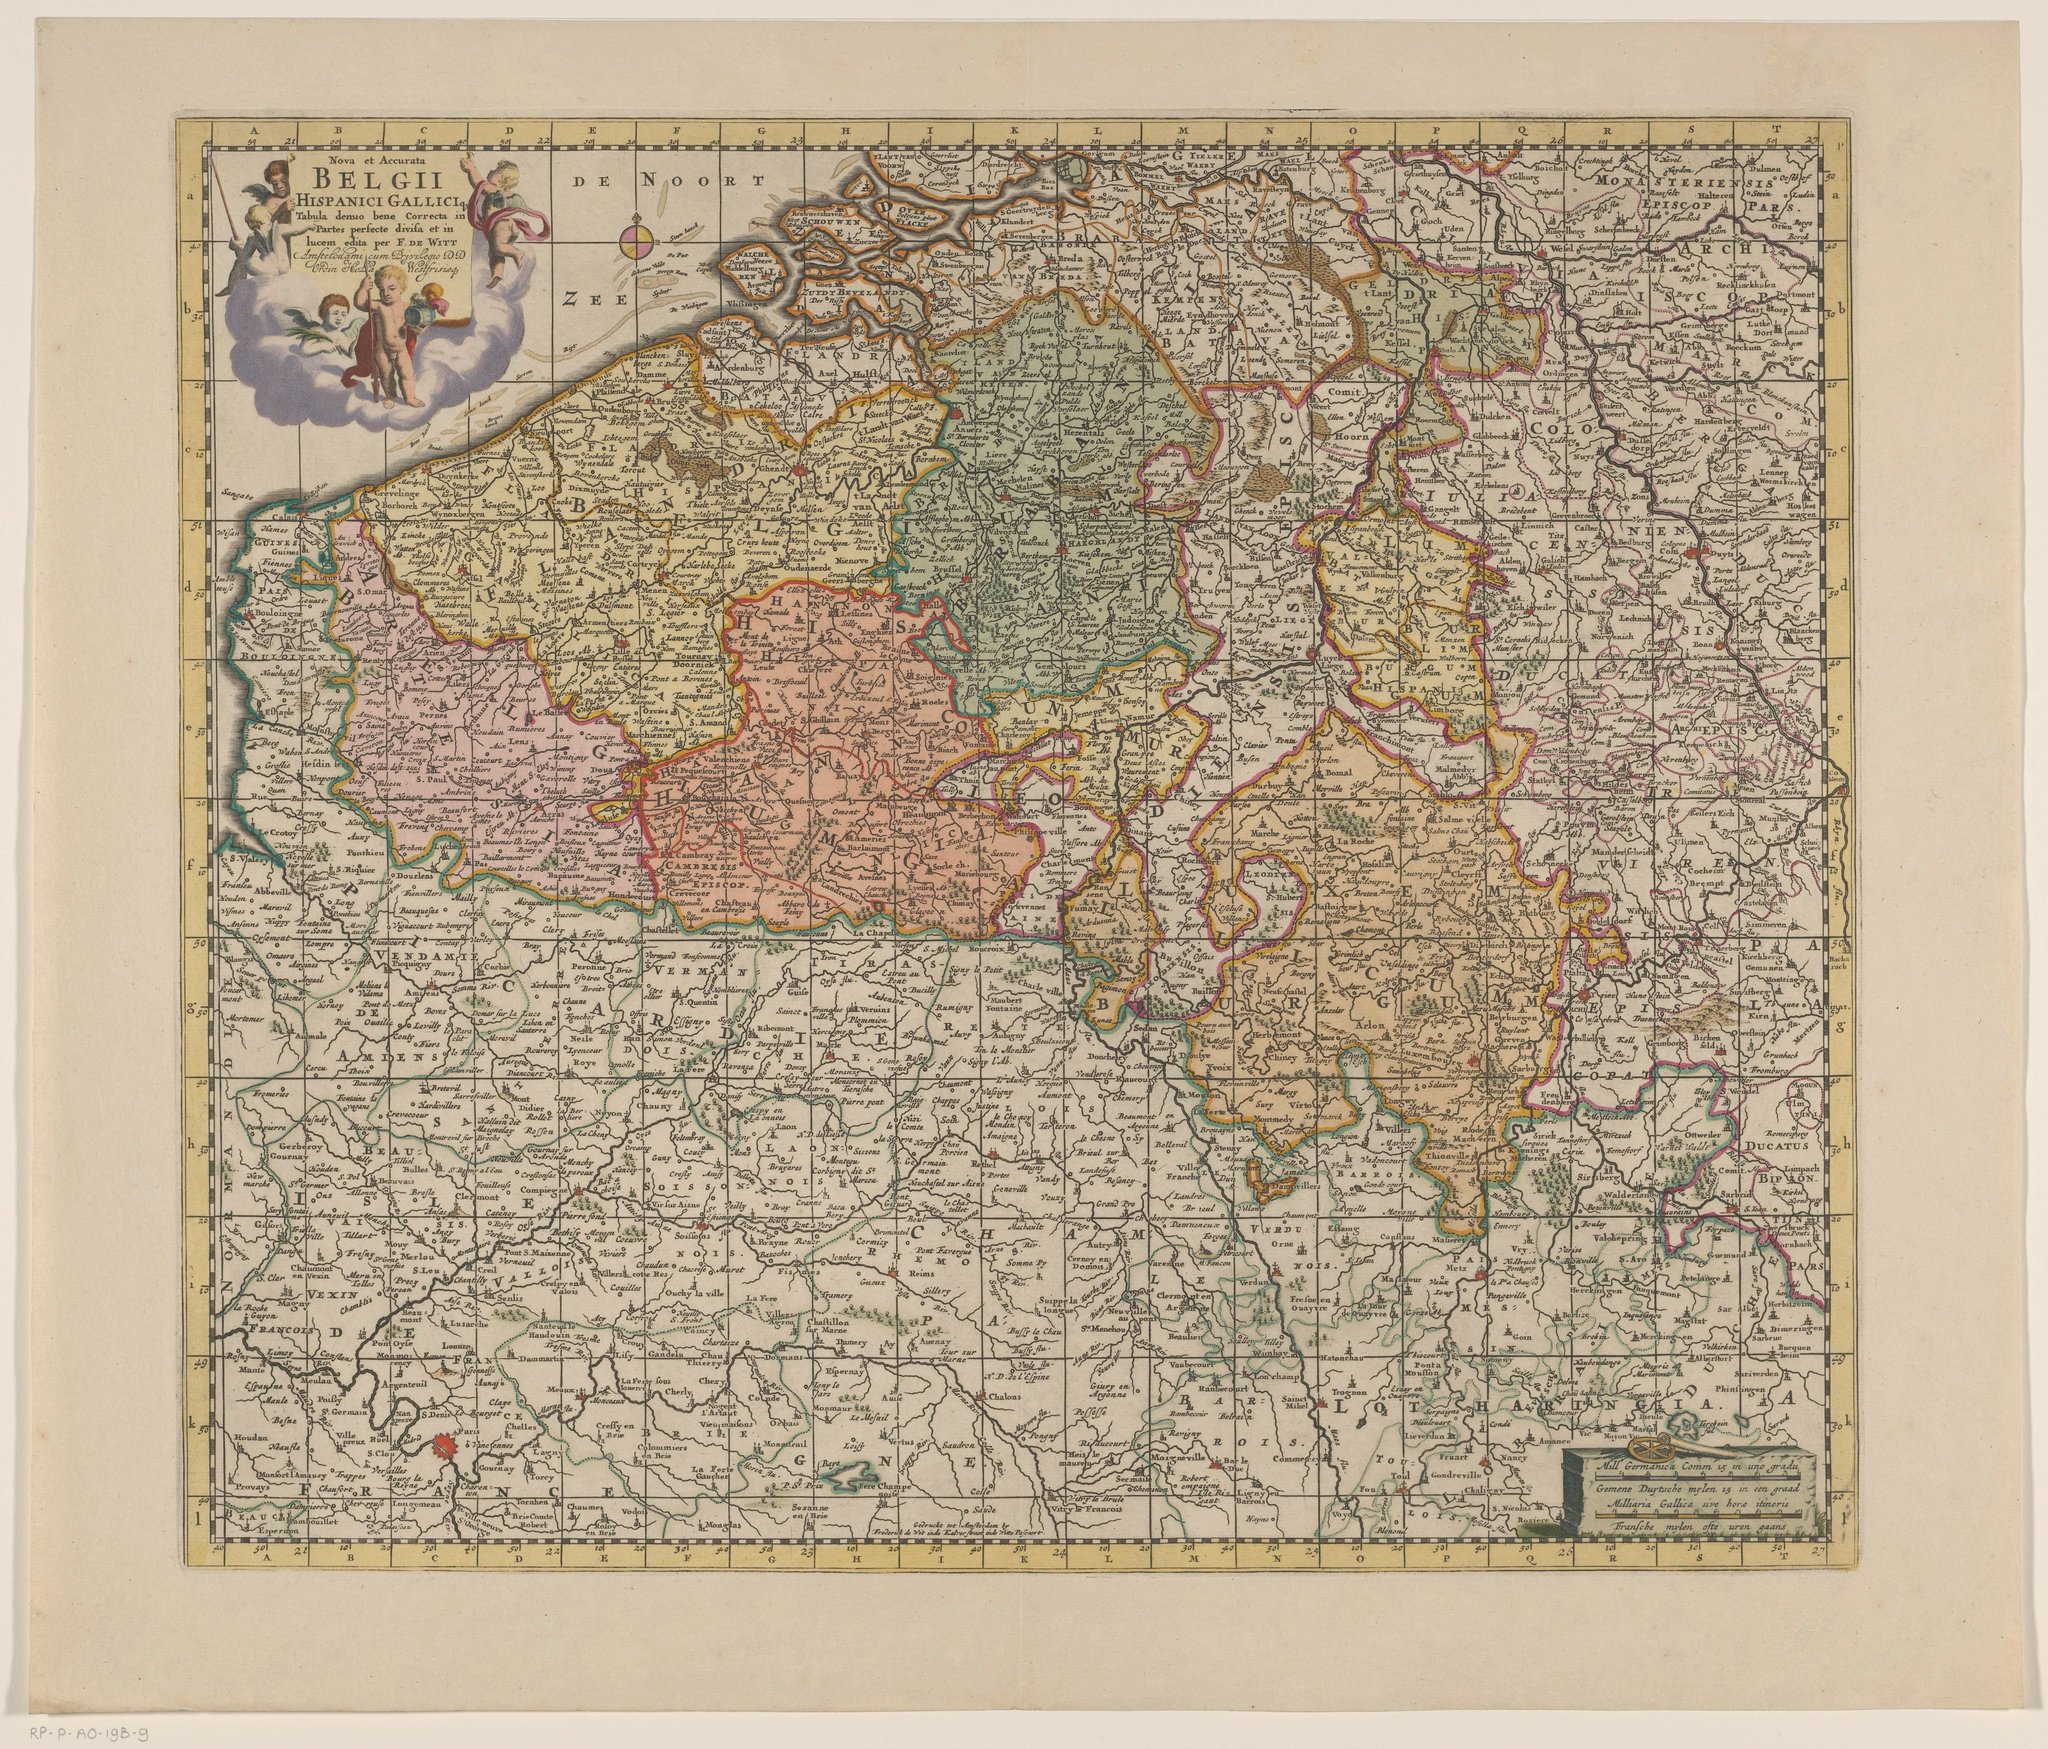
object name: print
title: Nova et accurata Belgii Hispanici Galliciq (...)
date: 1691-1706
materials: paper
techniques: engraving, hand coloring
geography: amsterdam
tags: maps of separate countries or regions, southern netherlands, belgium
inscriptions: collector's mark: Lugt 2228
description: Kaart van de Zuidelijke Nederlanden. Linksboven de titelcartouche. Rechtsonder een cartouche met twee schaalstokken: 7 1/2 Gemene Duytsche mylen 15 in een graad / 10 Fransche mylen ofte uren gaans. De kaart is voorzien van een zoekrooster en een gradenverdeling langs de randen.